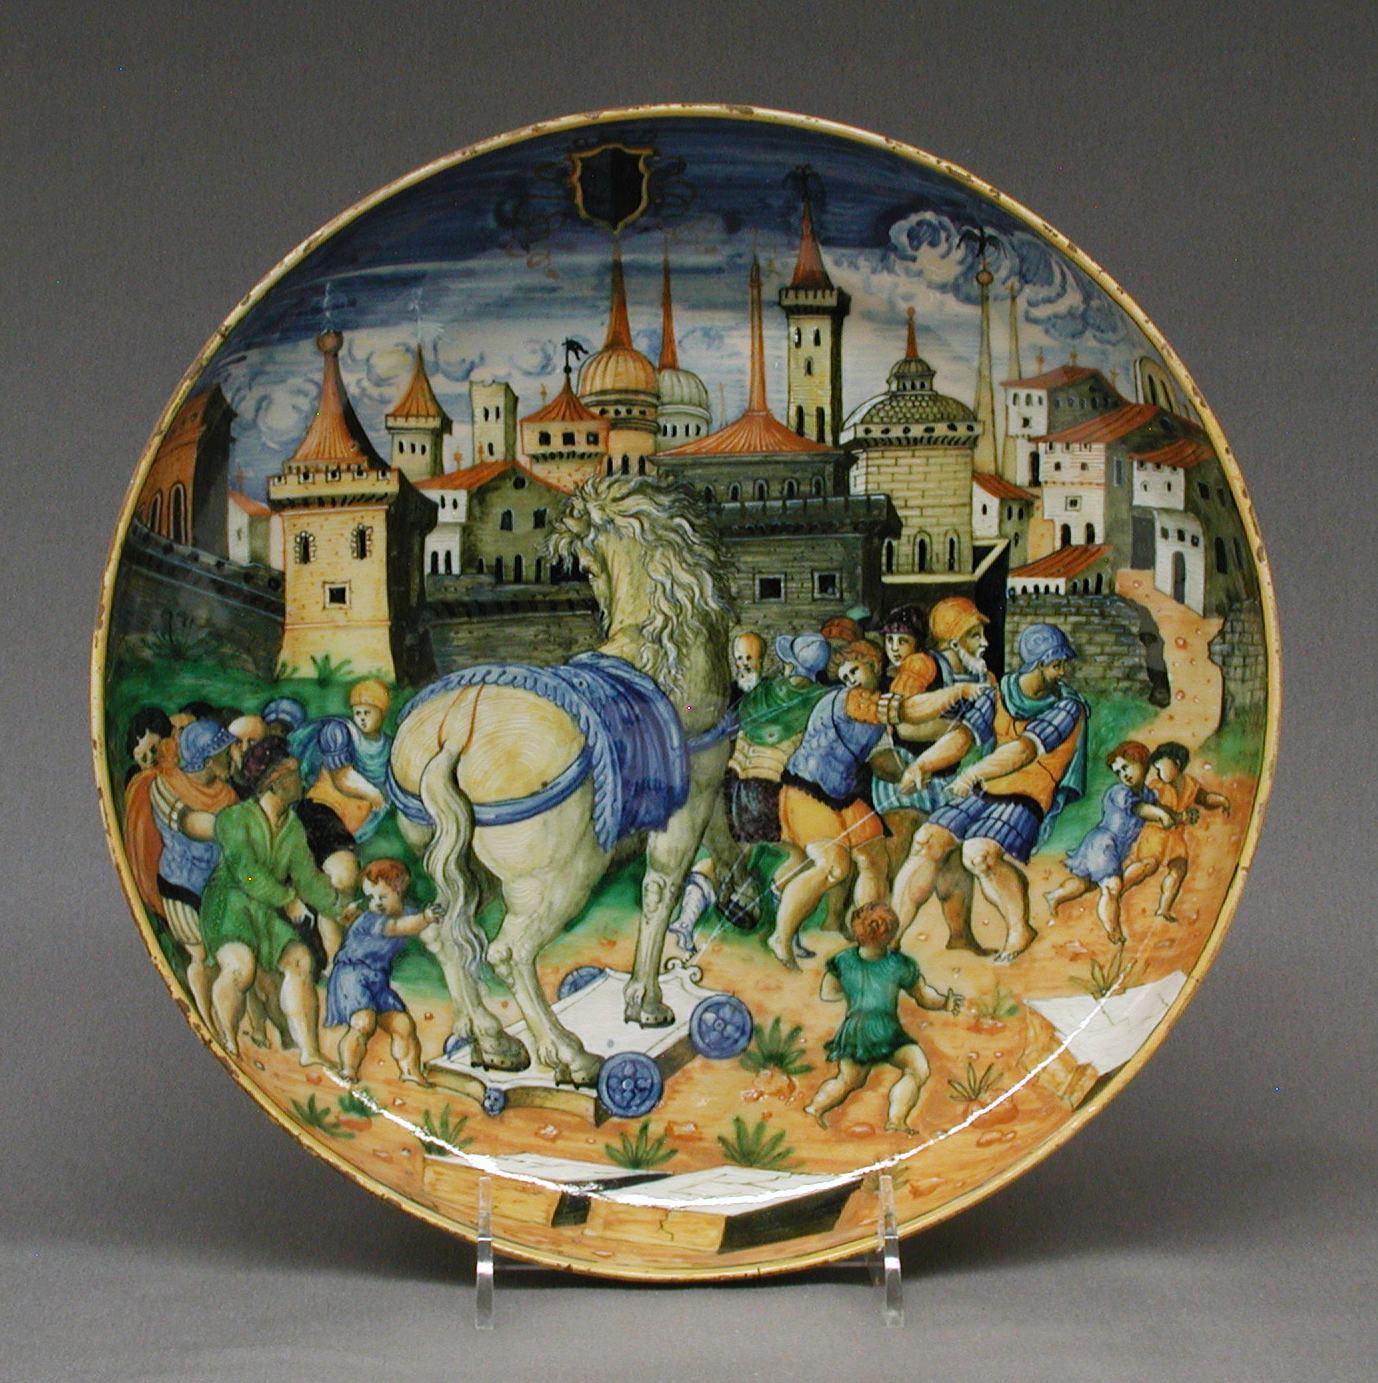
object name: dish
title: Dish depicting the Trojan Horse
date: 1534-1566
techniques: maiolica, glazing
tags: trojan war,children,men,horses